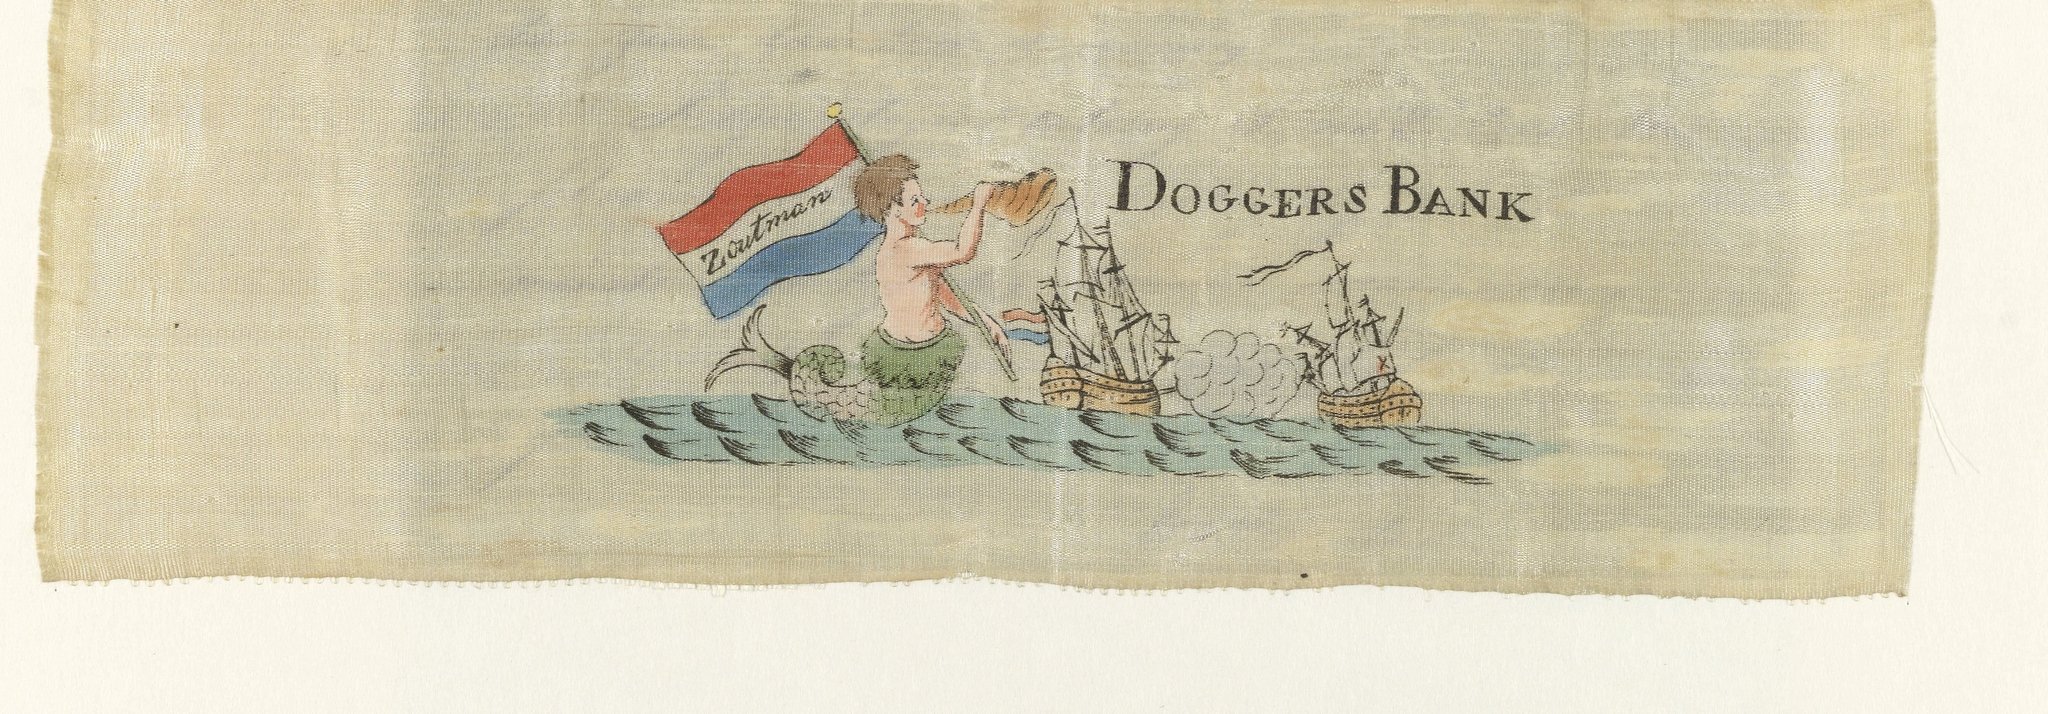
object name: print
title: Doggersbanklint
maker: Anonymous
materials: silk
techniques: engraving, etching, hand coloring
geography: netherlands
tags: the hague, johan arnold zoutman, battle (+ naval force)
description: Allegorie op de overwinning in de zeeslag bij Doggersbank op 5 augustus 1781 tussen de Nederlandse en de Engelse vloot. Een triton met de Nederlandse vlag waarop de naam van Zoutman blaast op een hoorn, op de achtergrond de zeeslag. Voorstelling op een zijden lint dat als versiering aan de hoed werd gedragen.